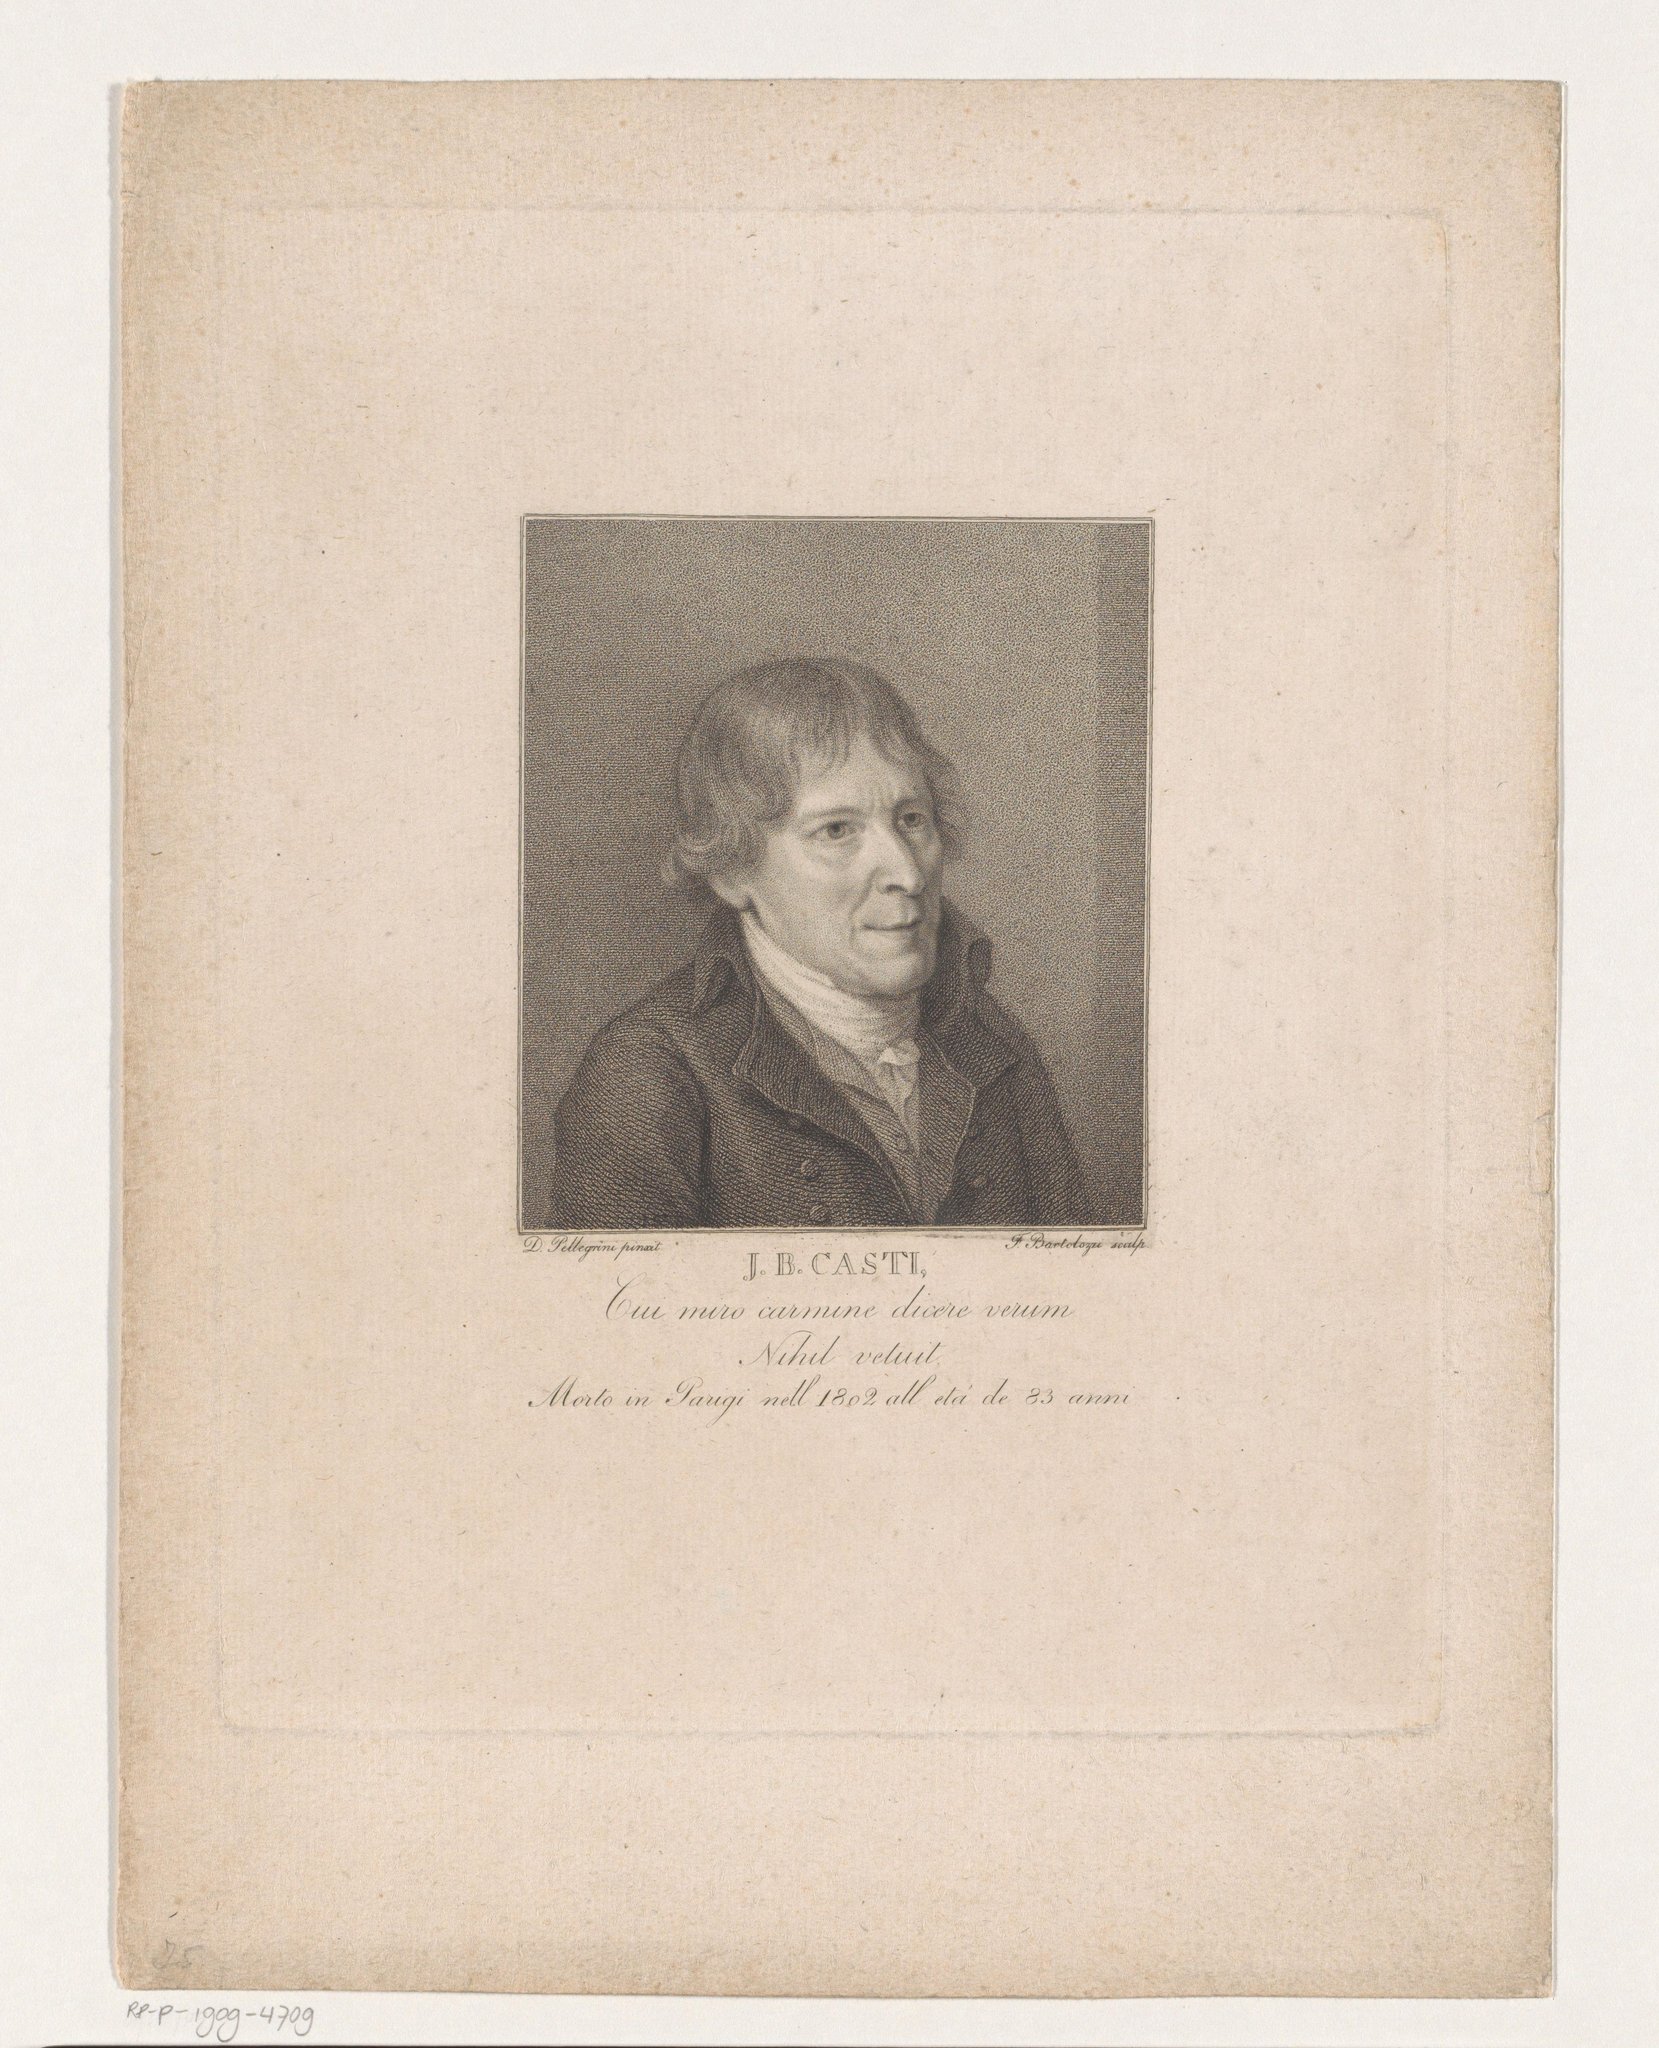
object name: print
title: Portret van Giovanni Battista Casti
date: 1738-1815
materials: paper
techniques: etching, engraving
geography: italy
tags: paris, historical persons, portrait of a writer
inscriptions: collector's mark: Lugt 2228